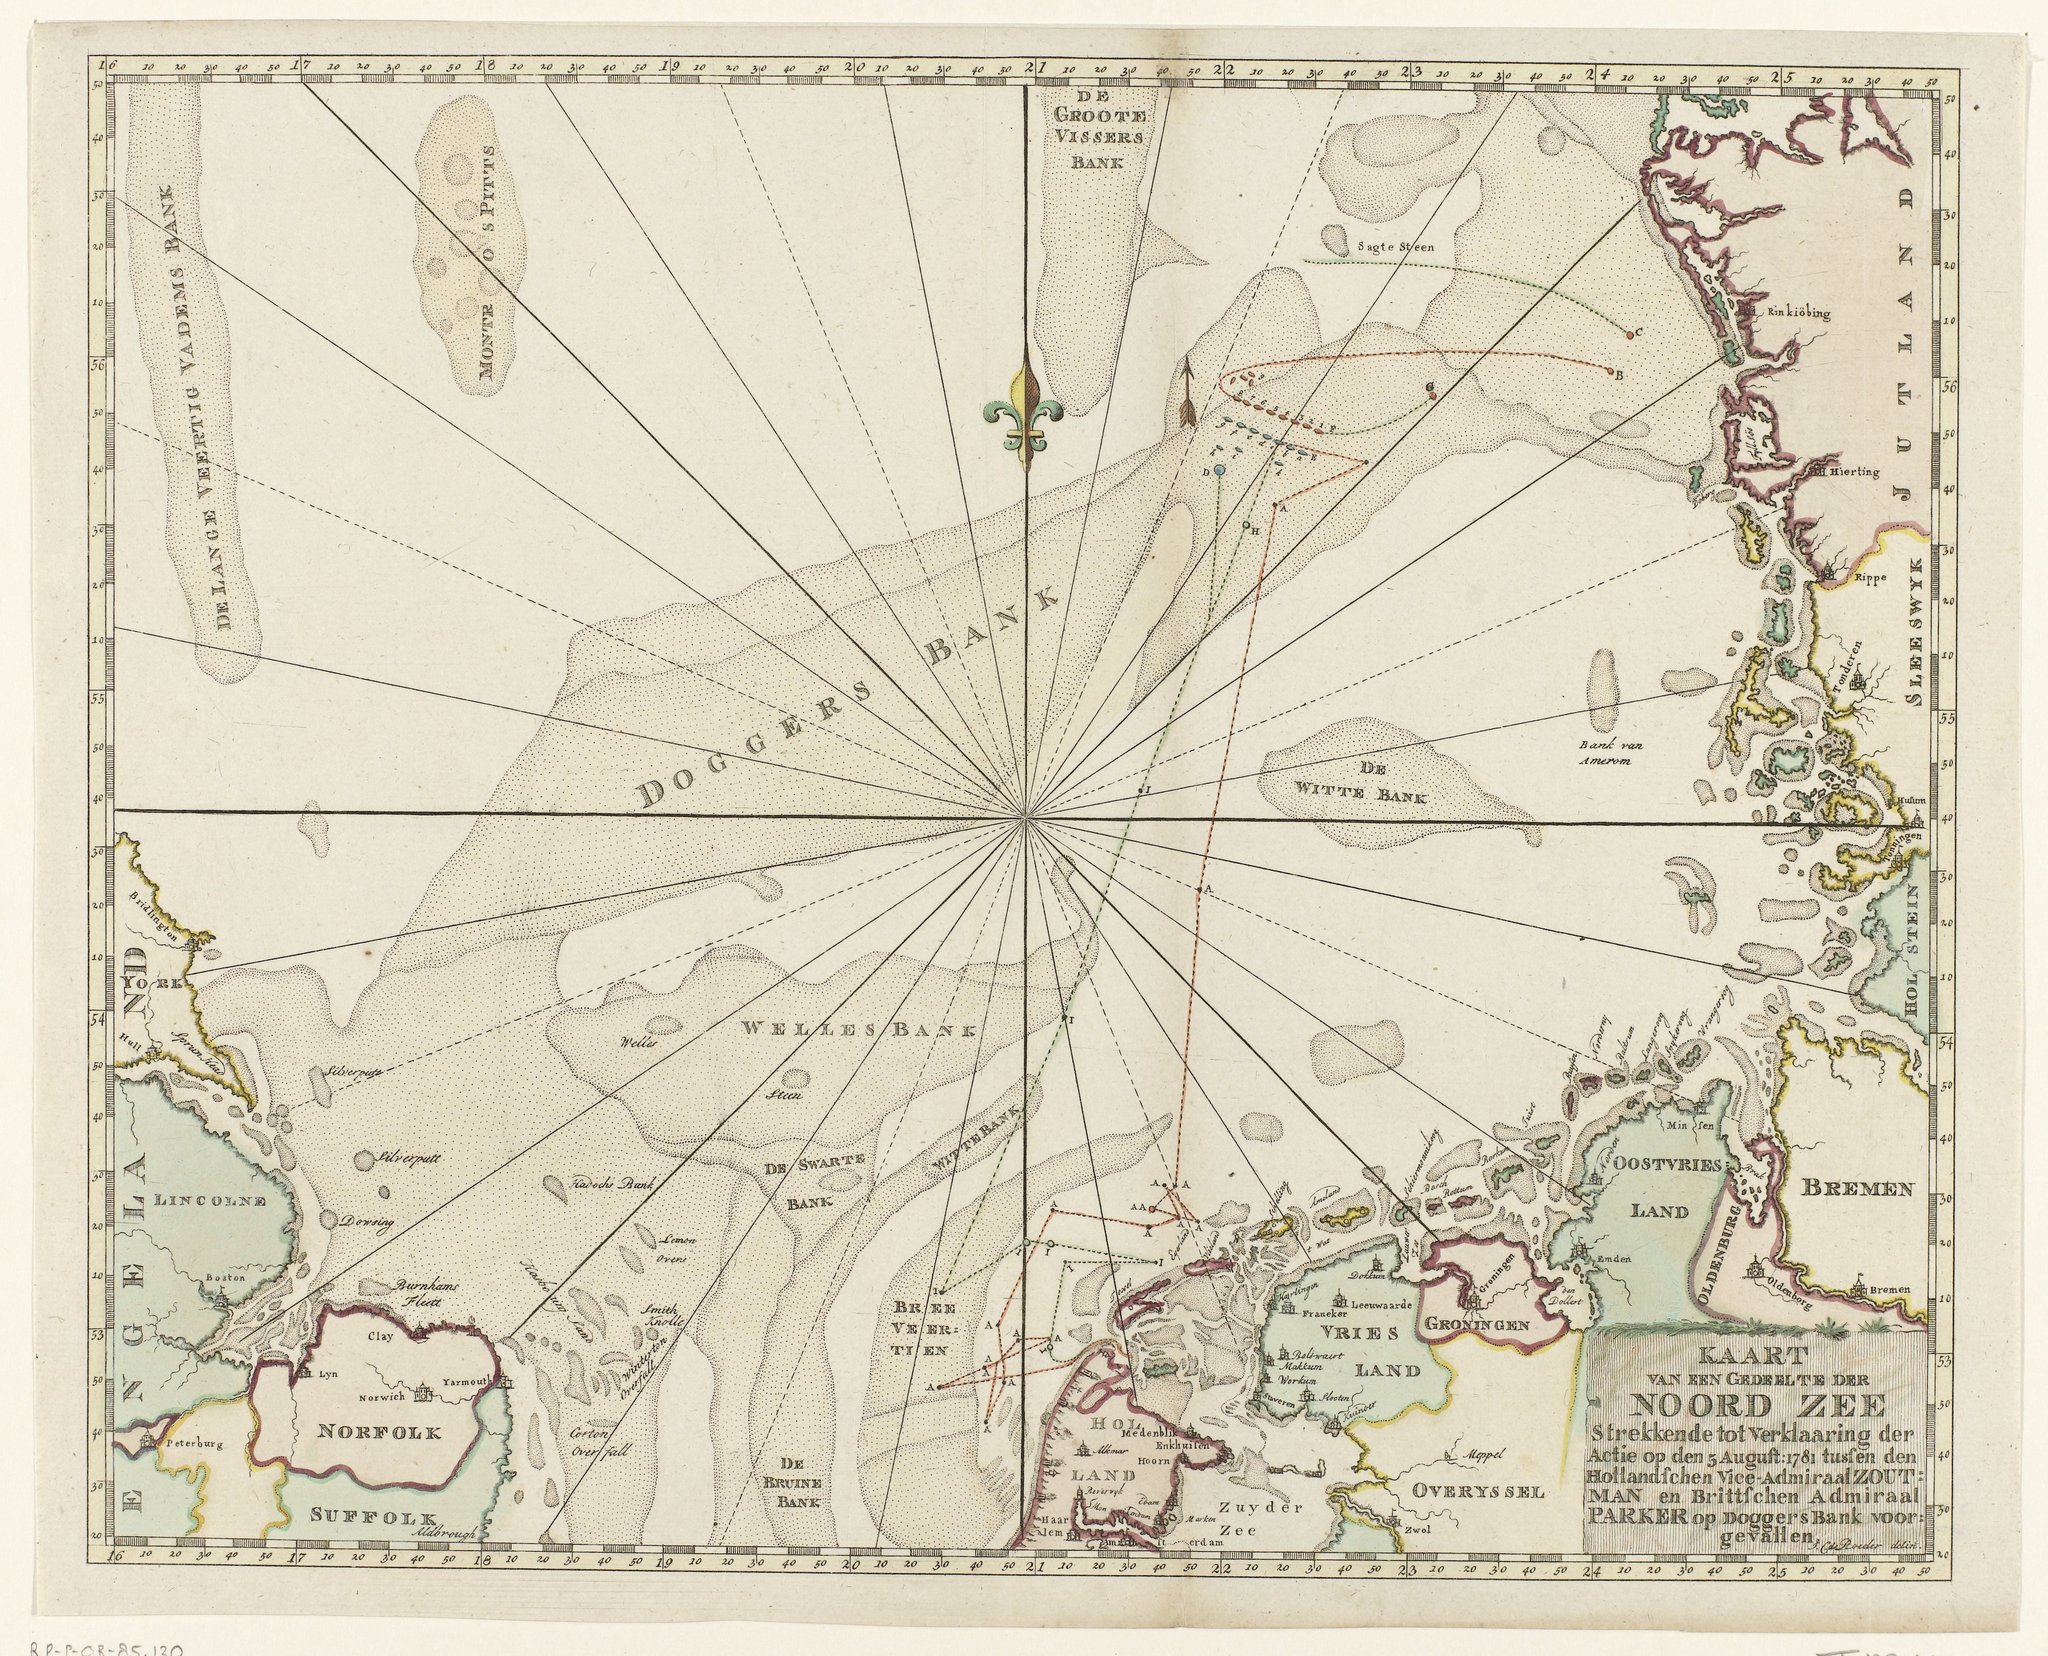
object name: print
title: Kaart van een Gedeelte der Noord Zee Strekkende tot Verklaaring der Actie op den 5 Augustus: 1781 tussen den Hollandschen Vice-Admiraal Zout:Man en Brittschen Admiraal Parker op Doggers Bank voorgevallen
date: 1781-1783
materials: paper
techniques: etching, hand coloring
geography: northern netherlands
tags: the hague, johan arnold zoutman, hyde parker, marine charts, battle (+ naval force)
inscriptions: collector's mark: Lugt 2228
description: Zeekaart van de Noordzee met de zeeslag bij Doggersbank op 5 augustus 1781 tussen de Nederlandse vloot onder schout-bij-nacht Johan Zoutman en de Engelse vloot onder vice-admiraal Hyde Parker.